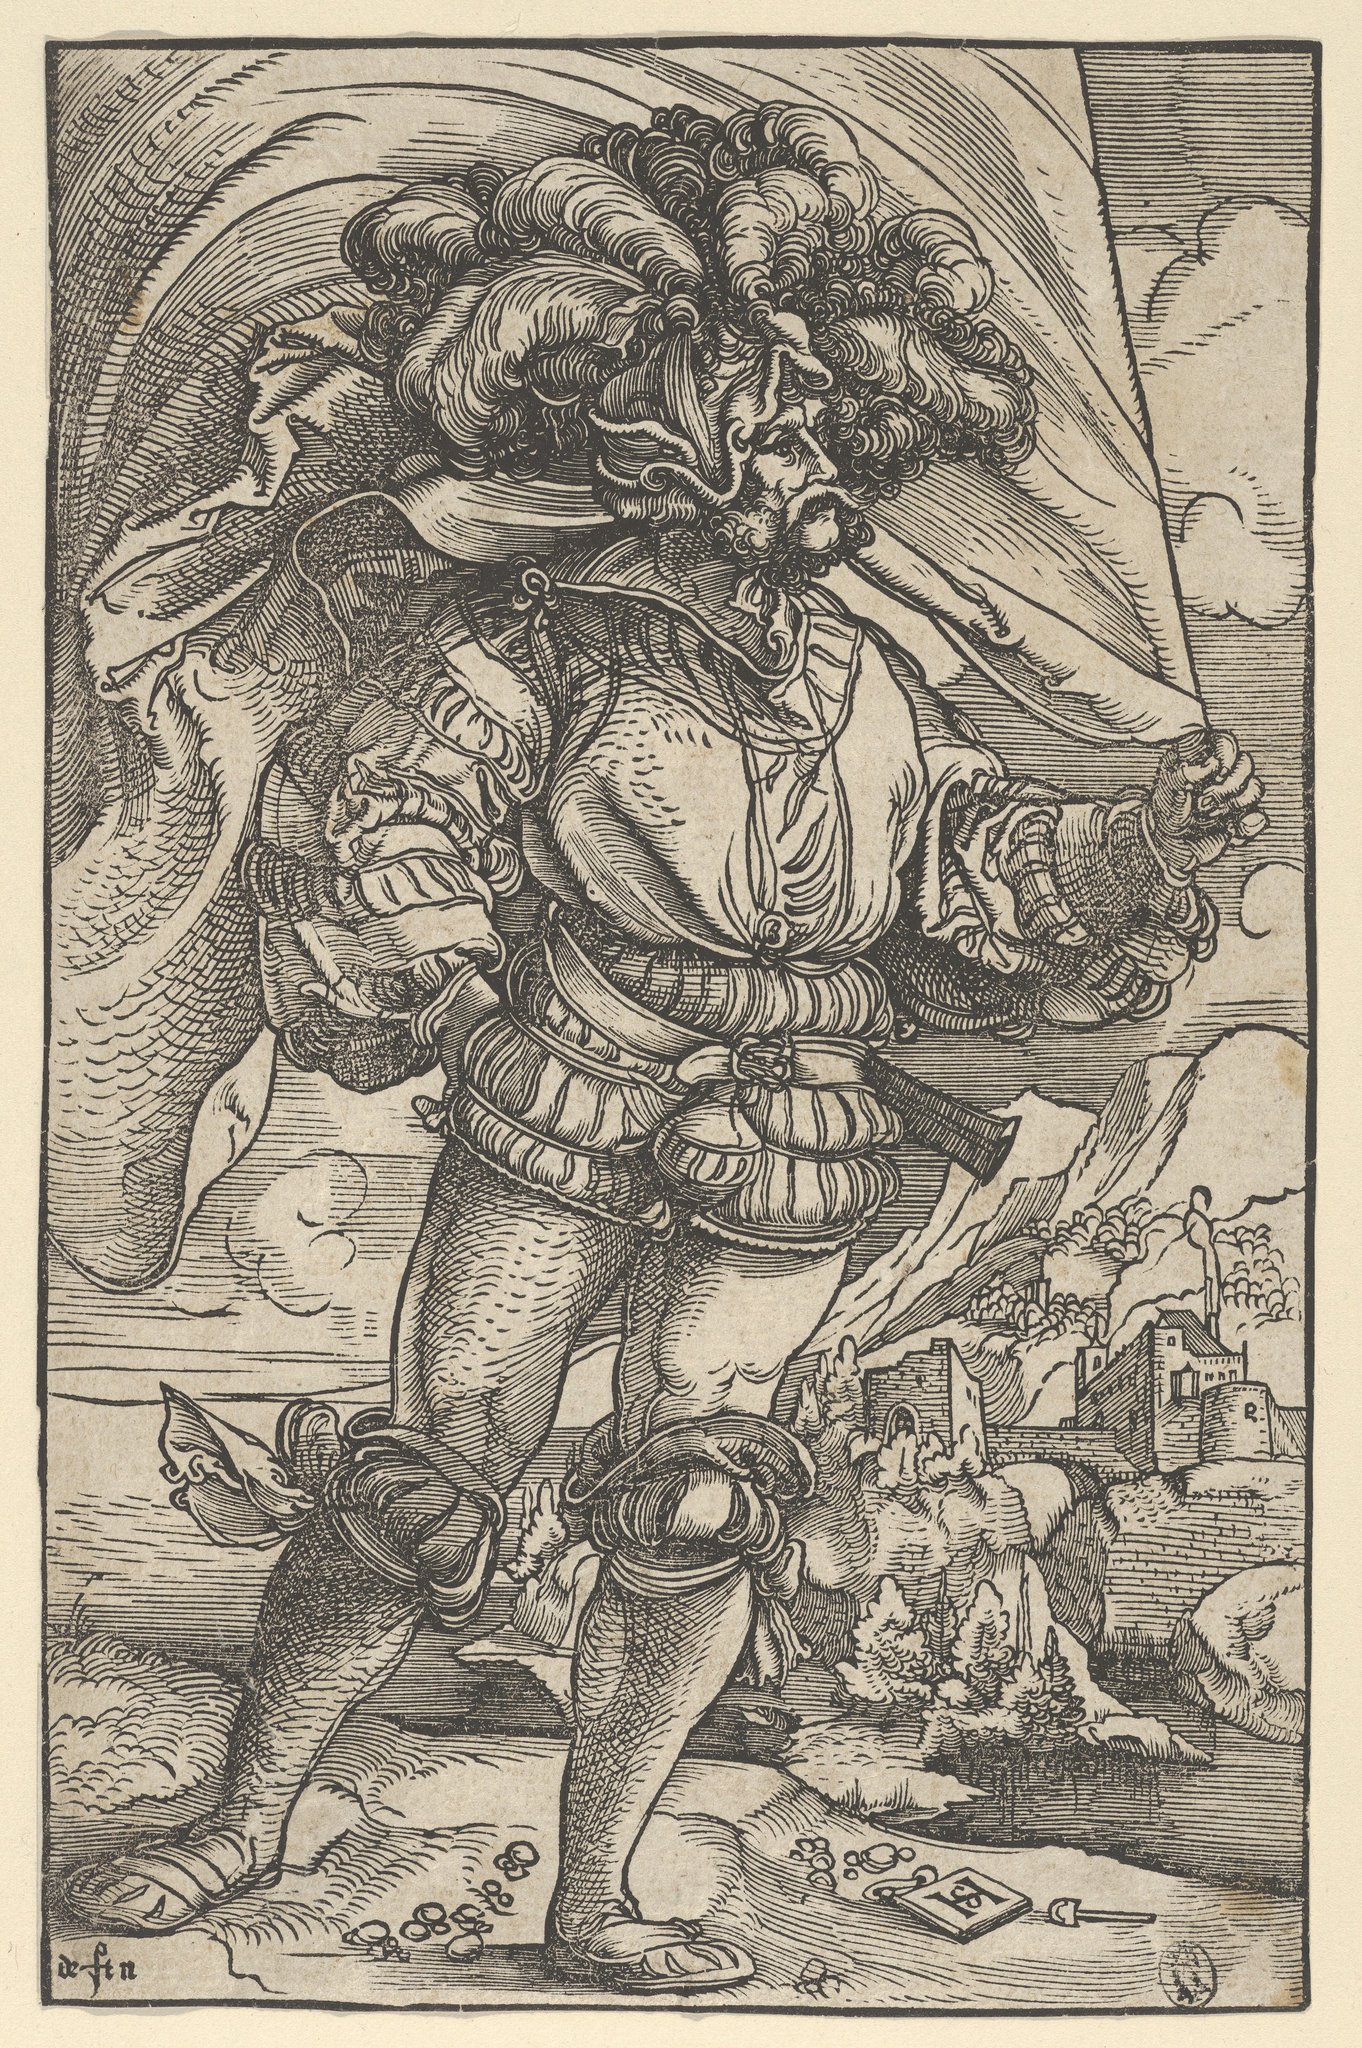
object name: print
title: The Standard Bearer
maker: hans schäufelein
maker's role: artist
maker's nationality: german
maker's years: 1480-1540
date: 1515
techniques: woodcut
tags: soldiers